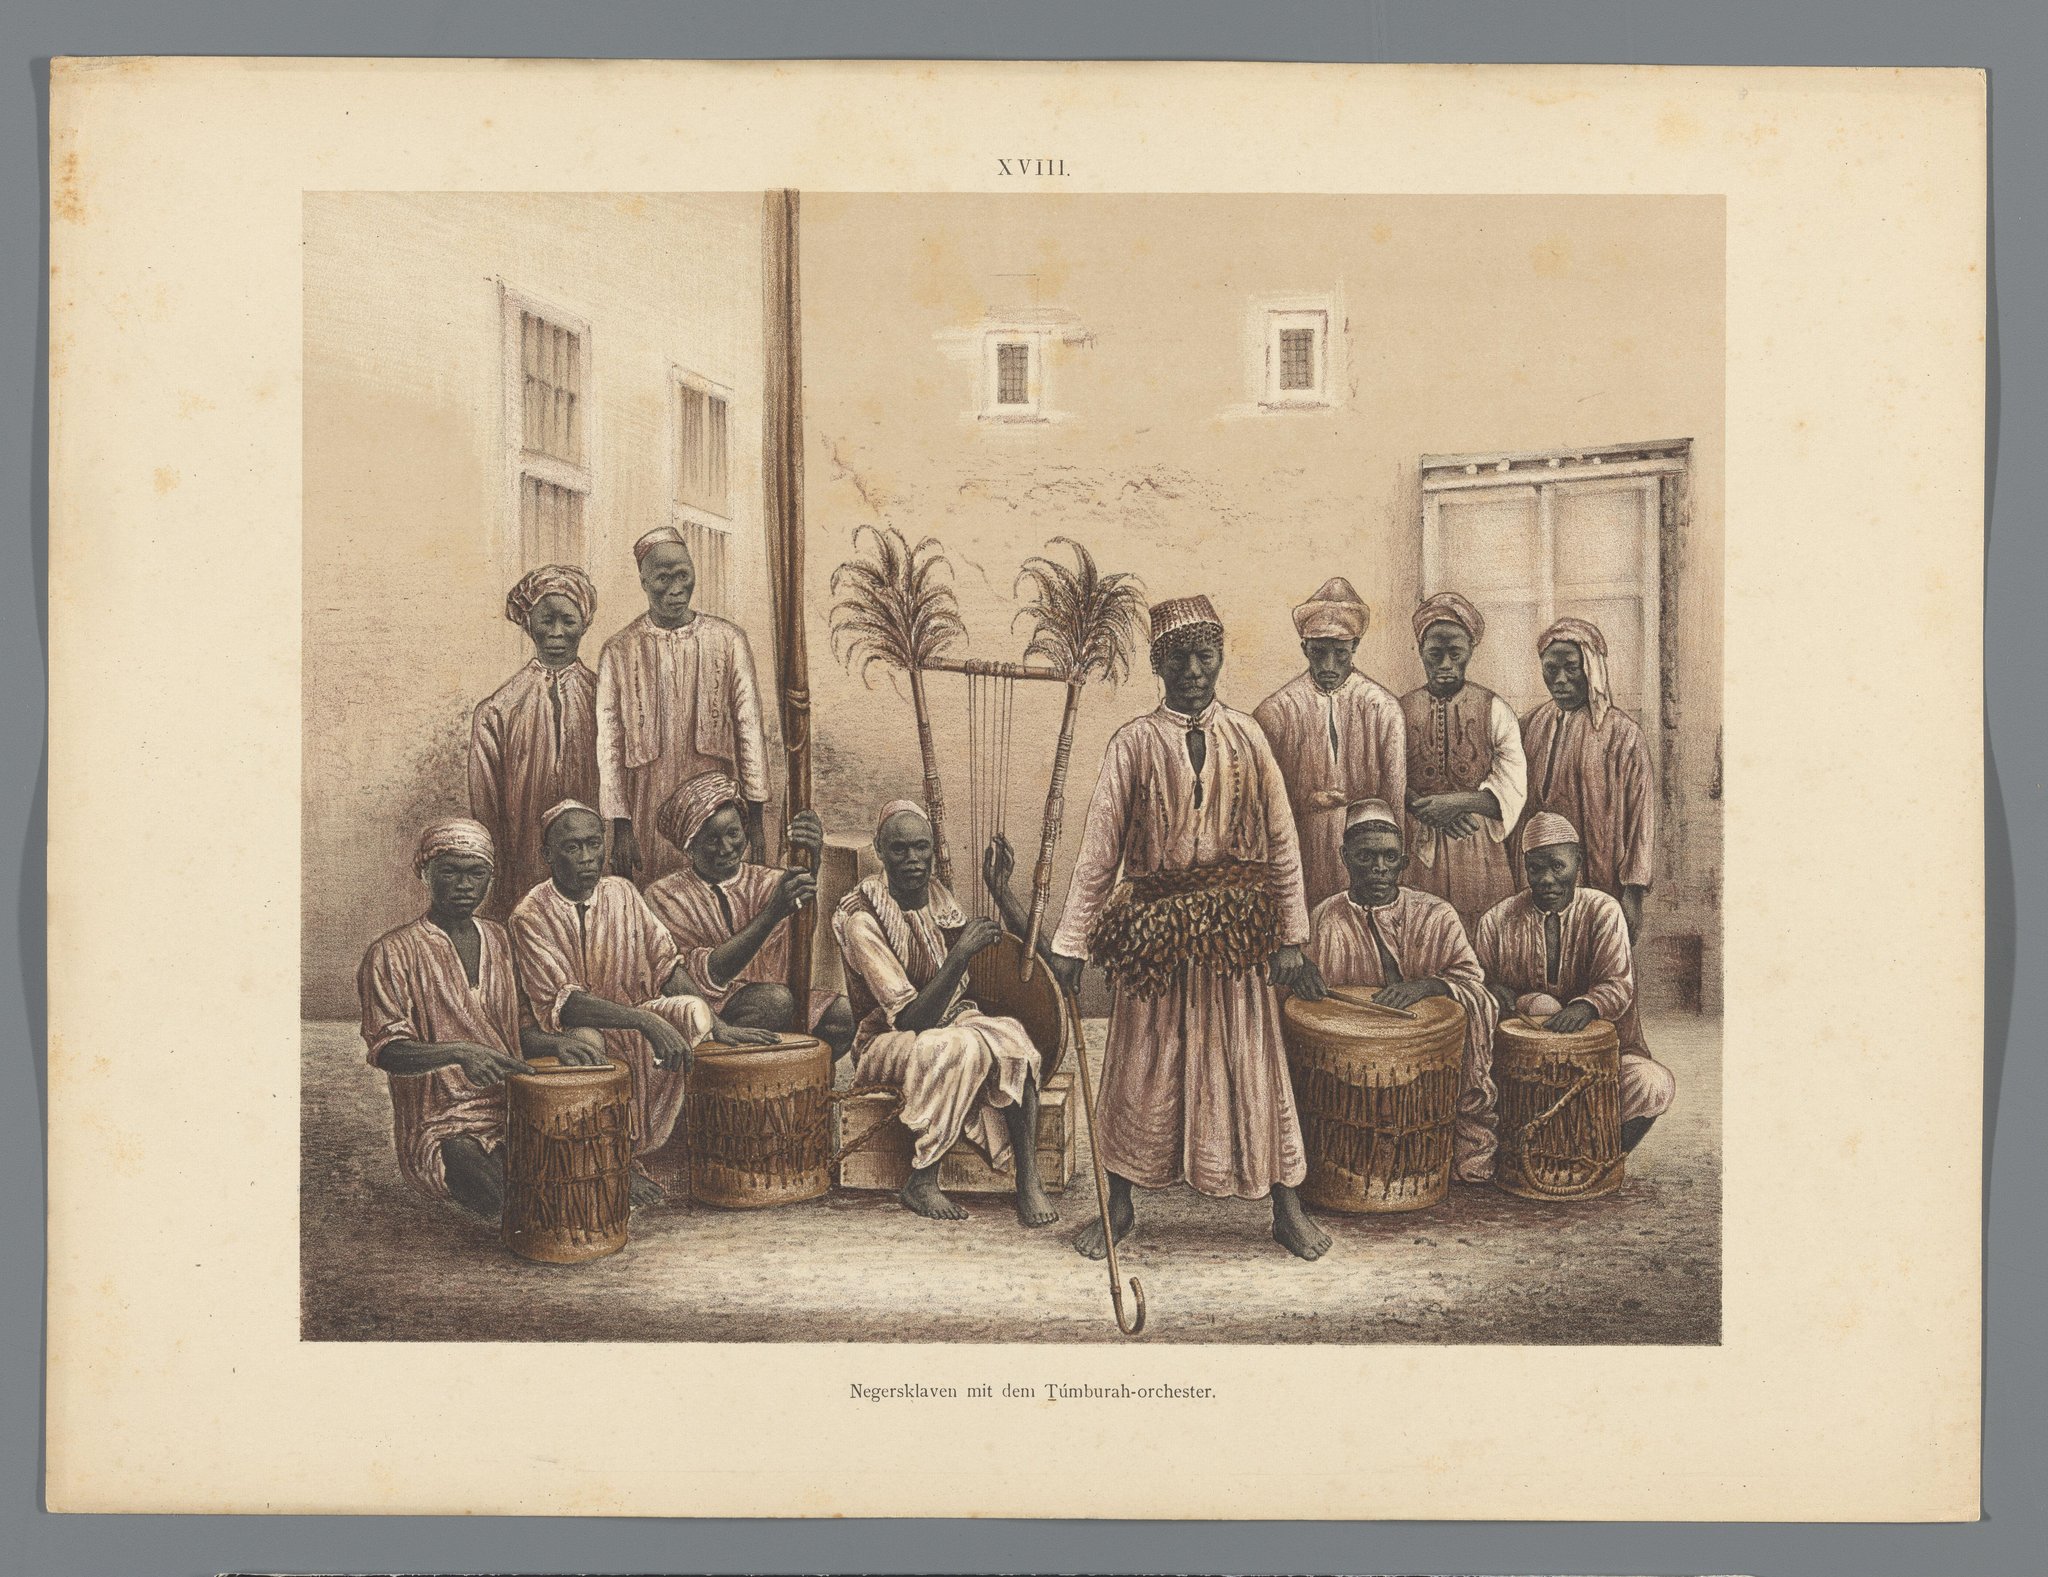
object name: print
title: Orkest bestaande uit tot slaaf gemaakte mannen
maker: Anonymous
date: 1883-1888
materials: paper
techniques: lithograph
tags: musician at work - cc - out of doors, slavery; serfs and enslaved persons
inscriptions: number: ‘XVIII.’